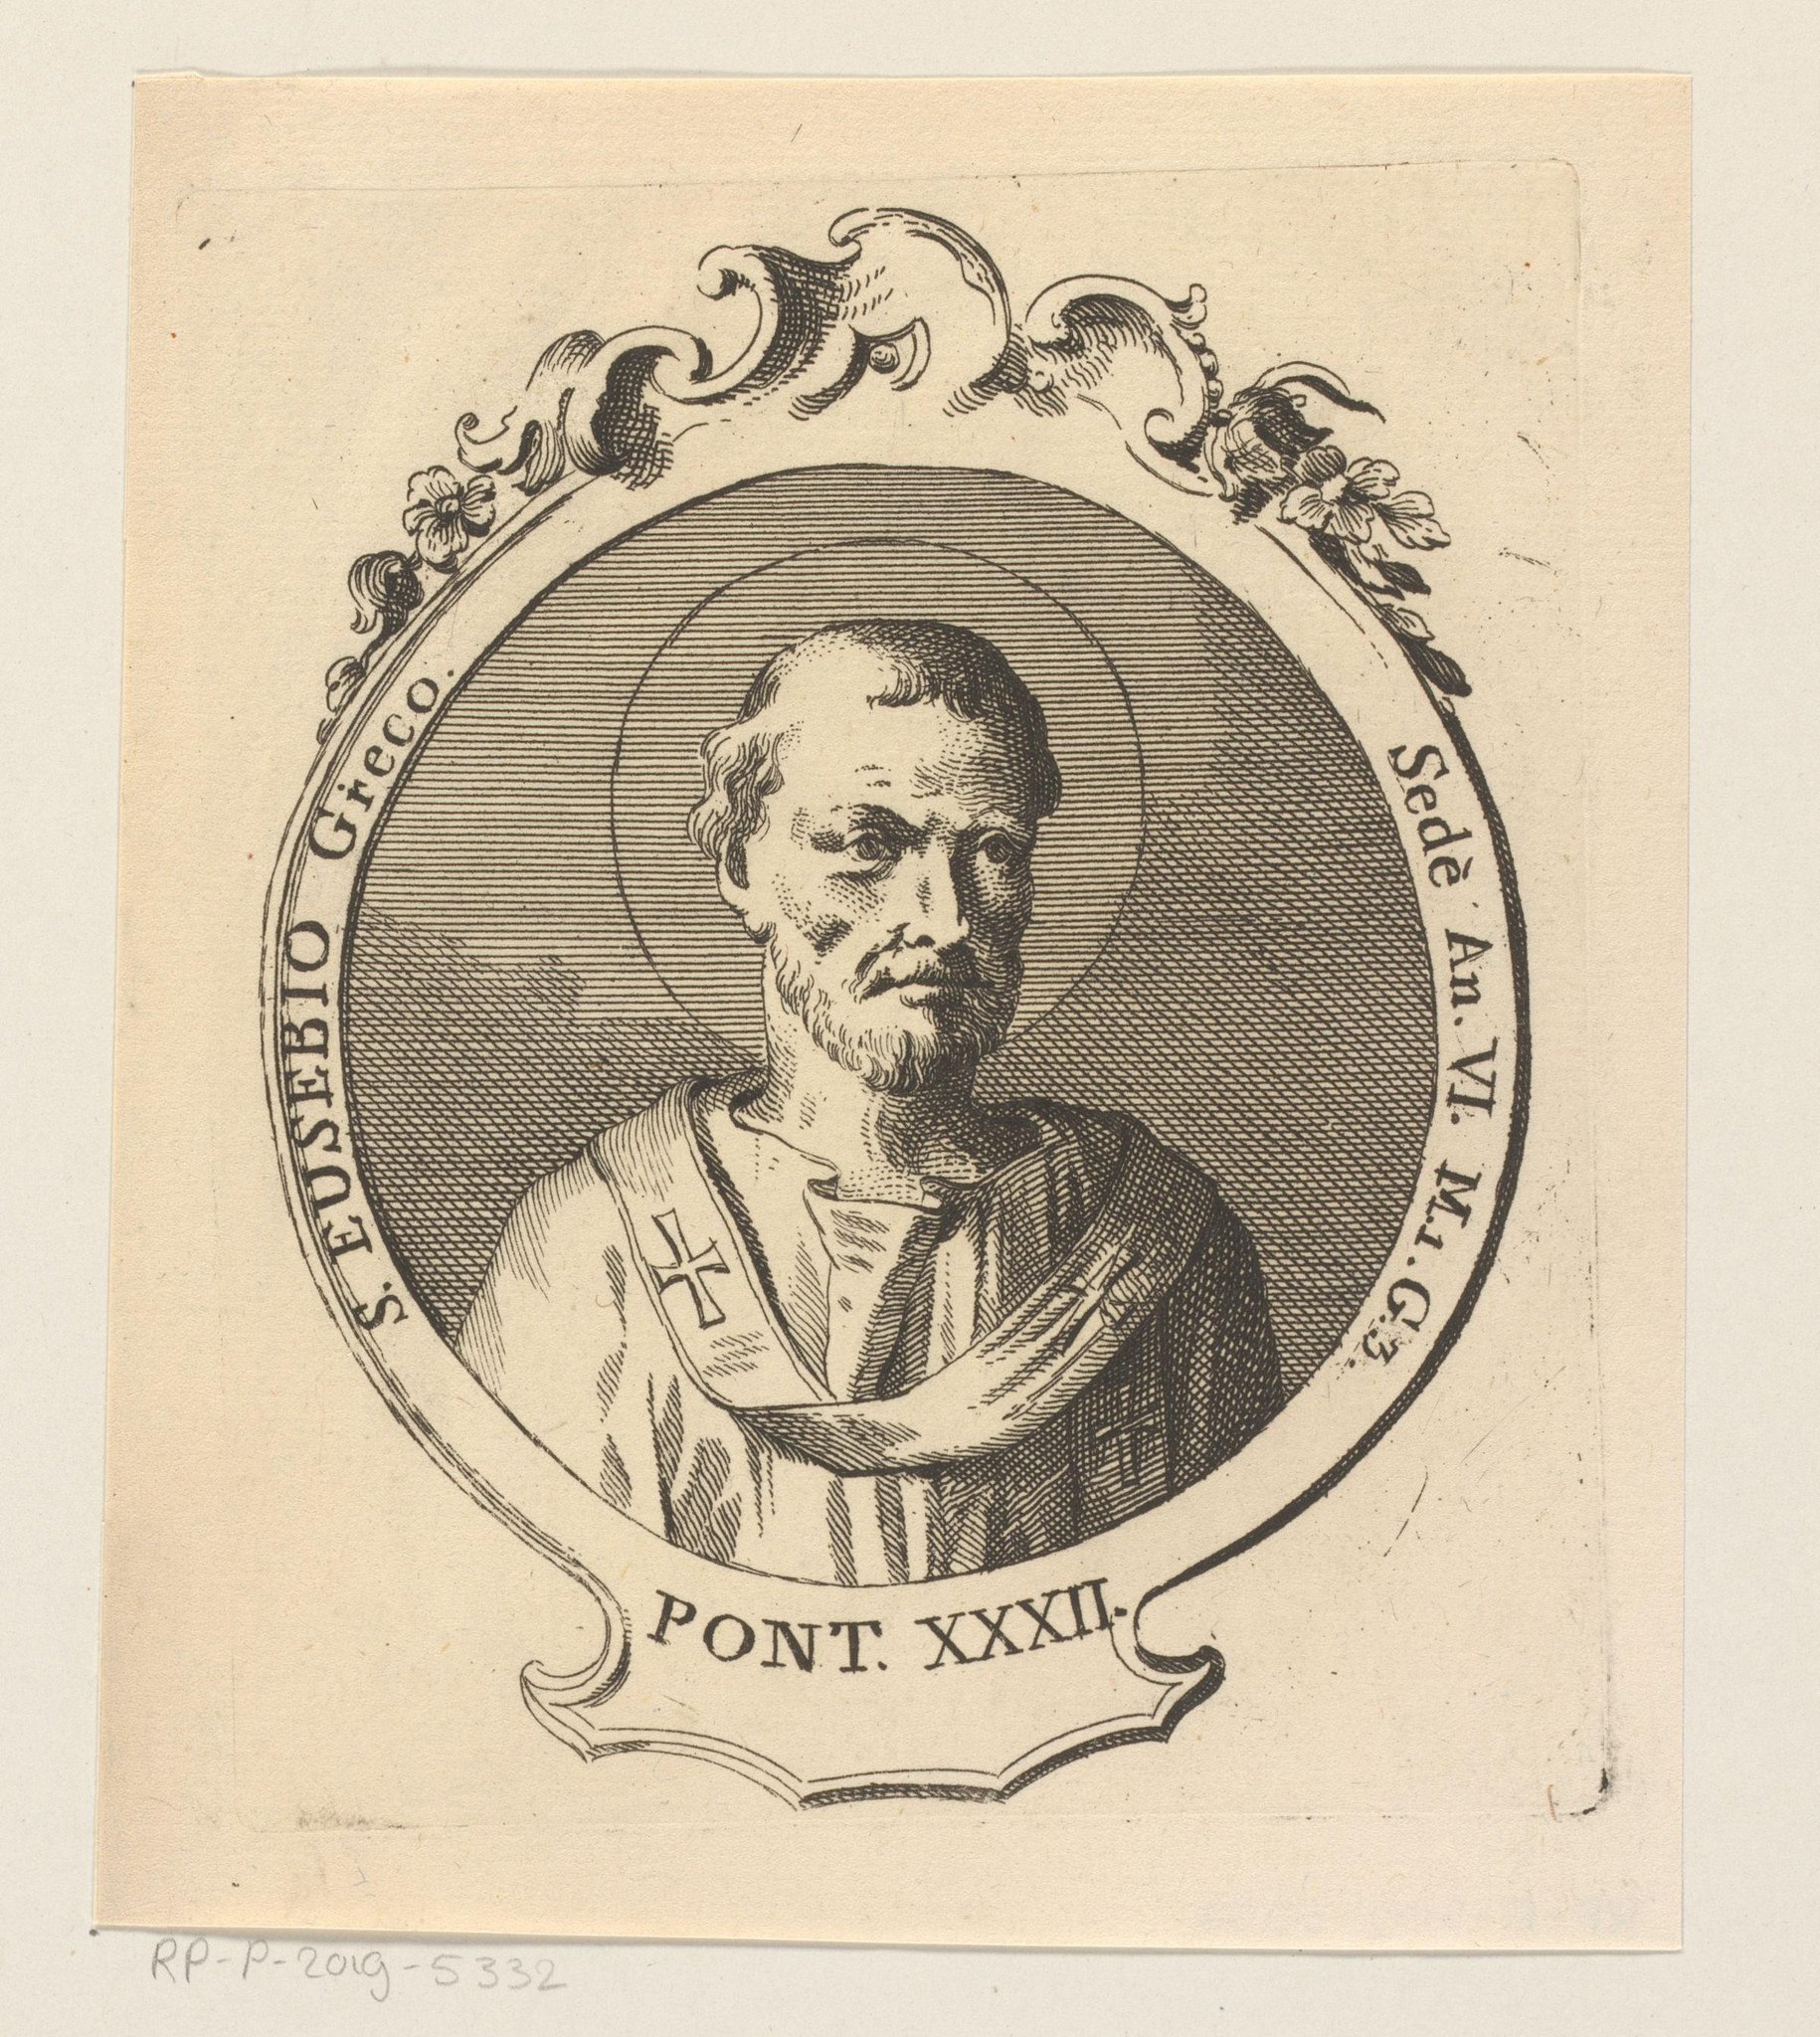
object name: book illustration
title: Portret van paus Eusebius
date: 1775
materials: paper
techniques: engraving, etching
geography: bassano del grappa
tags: historical persons, pope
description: Prent uit: Effigies Romanorum pontificum a S. Petro ad Pium VI. feliciter regnantem (...). 2 dln. Venetië en Bassano del Grappa: Giuseppe Remondini, 1775.